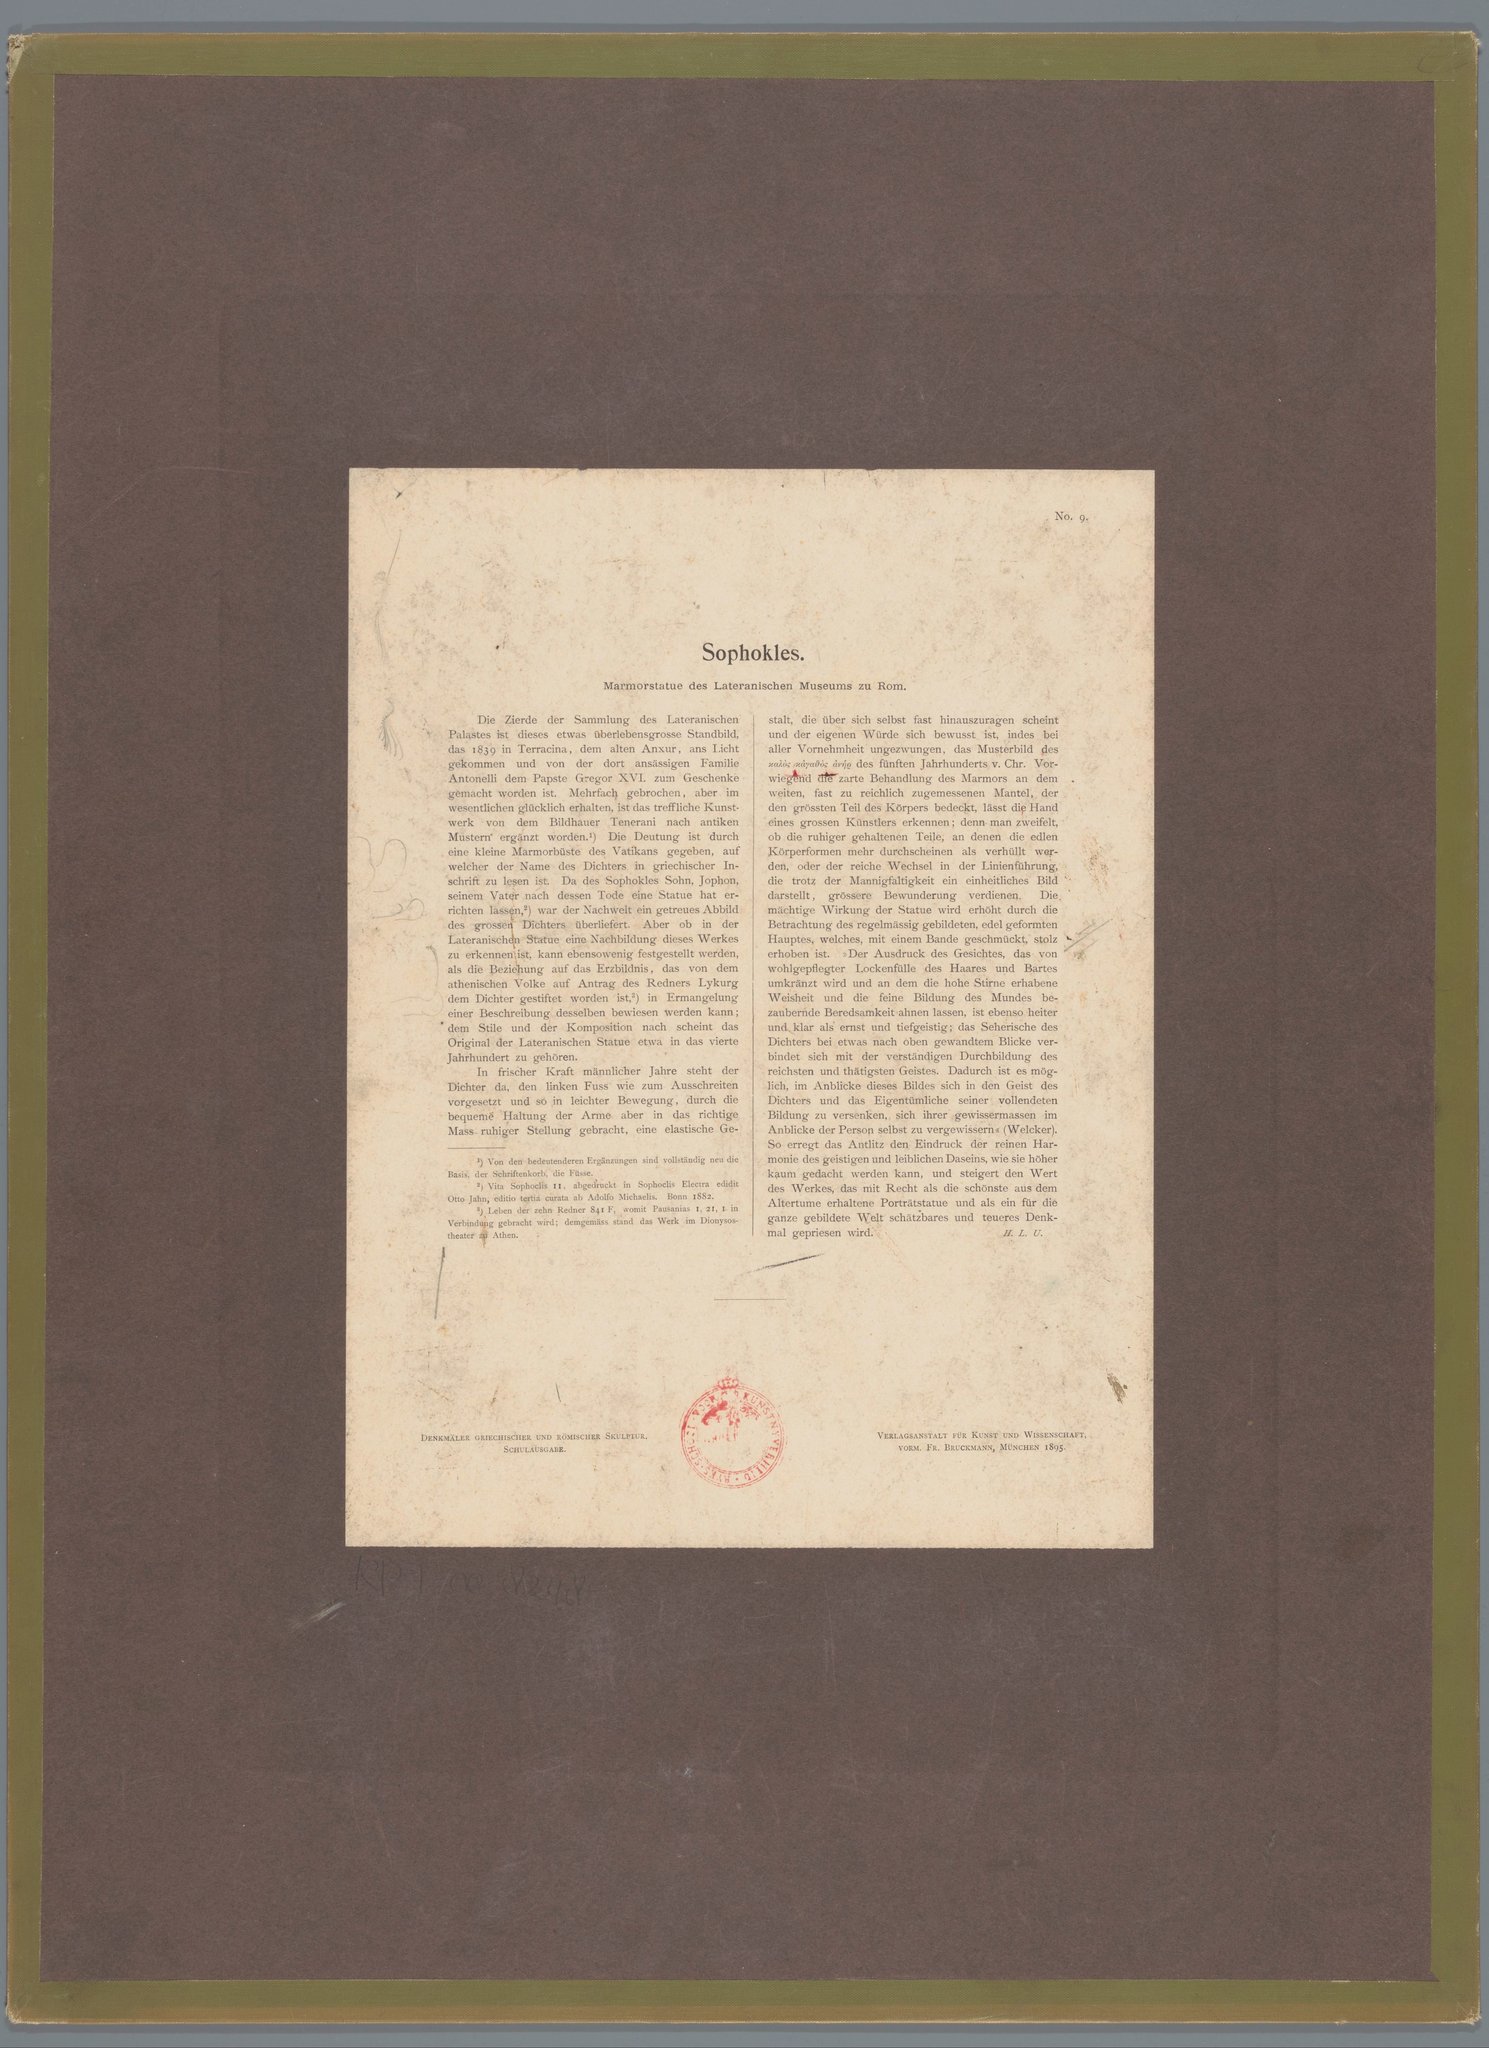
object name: photograph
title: Sophokles.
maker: Anonymous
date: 1895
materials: cardboard, paper, ink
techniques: photograph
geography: munich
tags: writer, poet, author, sculpture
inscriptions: collector's mark: Lugt 3937, number: ‘No. 9.’, inscription: